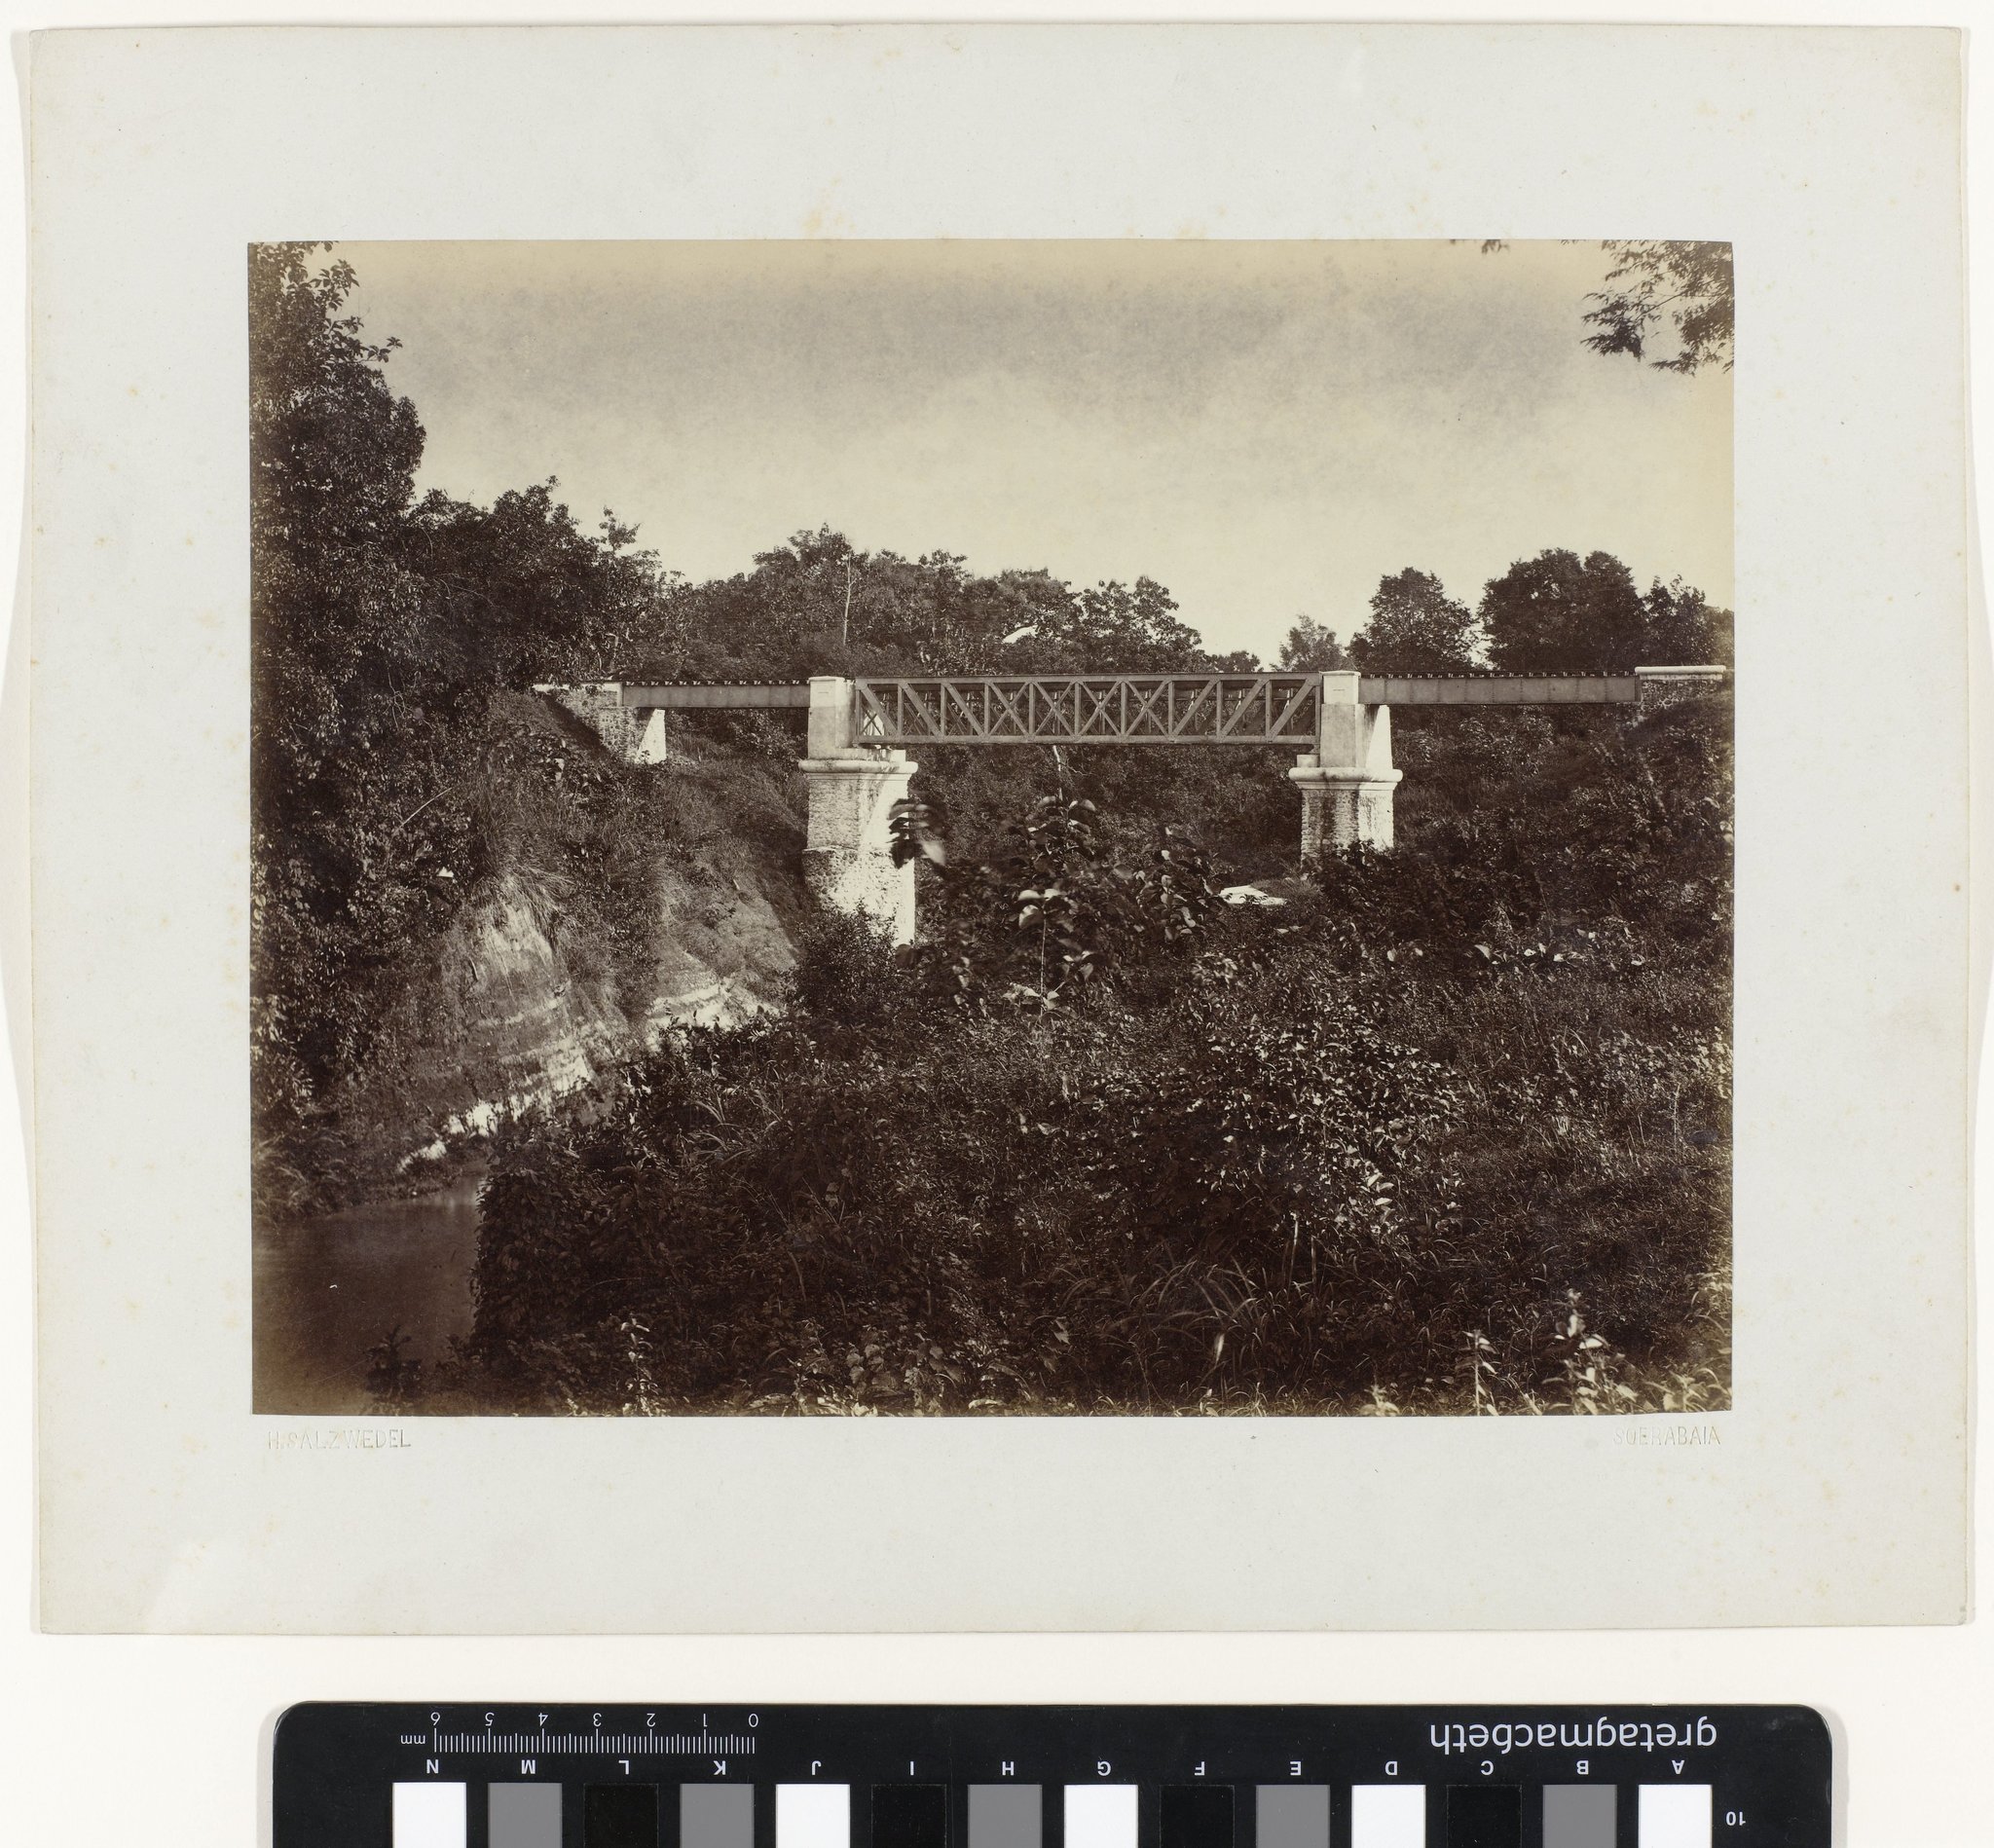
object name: photograph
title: Spoorwegbrug op Java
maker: herman salzwedel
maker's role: fotograaf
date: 1880-1888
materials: photographic support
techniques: albumen print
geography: surabaya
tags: java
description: Spoorwegbrug over een rivier op Java. Onderdeel van een groep van 62 foto's in een doos met het opschrift "Staatsspoorwegen op Java" uit 1888.